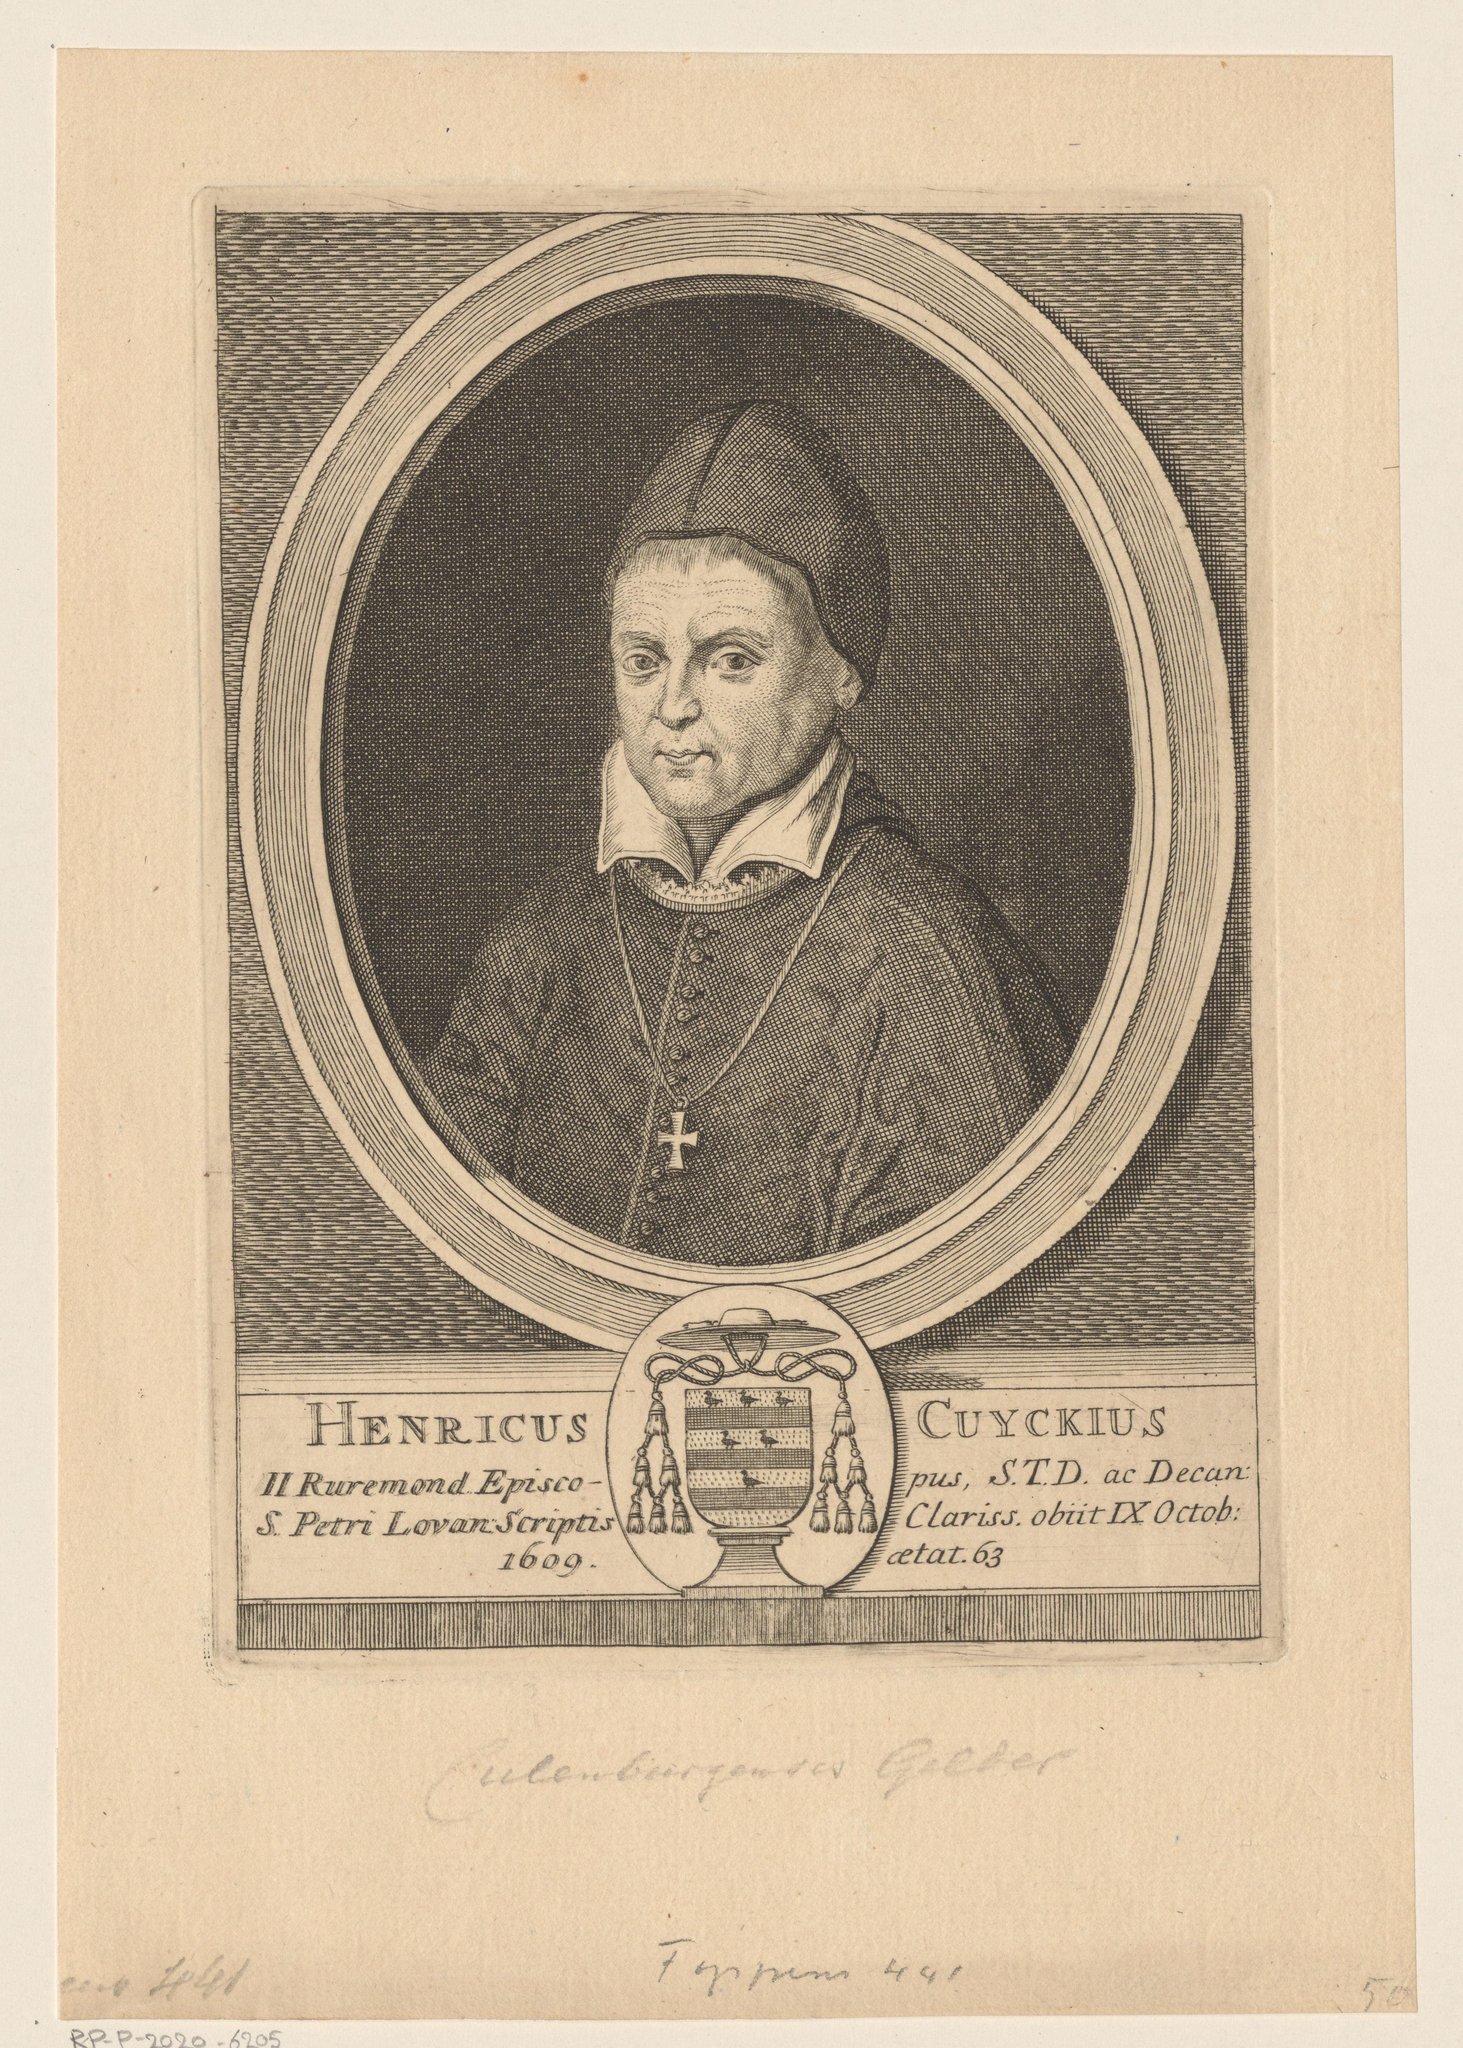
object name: print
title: Portret van Hendrik Cuyk op 63-jarige leeftijd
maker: Anonymous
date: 1609-1739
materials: paper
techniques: engraving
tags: historical persons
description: Prent mogelijk uit: Foppens, Joannis Francisci. Bibliotheca belgica, sive virorum in Belgio vita (...). Brussel: Petrum Foppens, 1739.